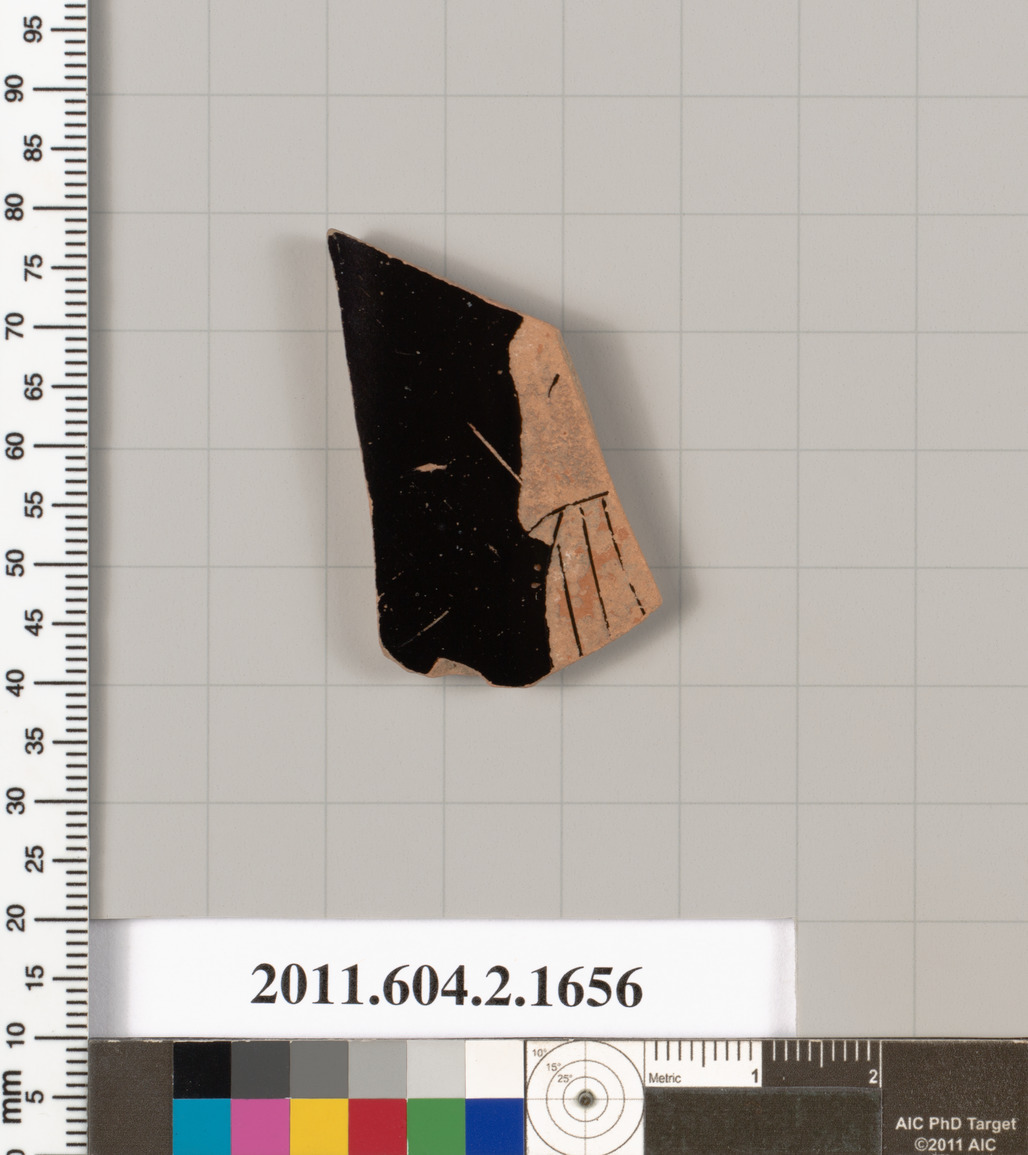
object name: skyphos fragment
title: Terracotta fragment of a skyphos (deep drinking cup)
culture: greek, attic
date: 475-451 BCE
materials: terracotta